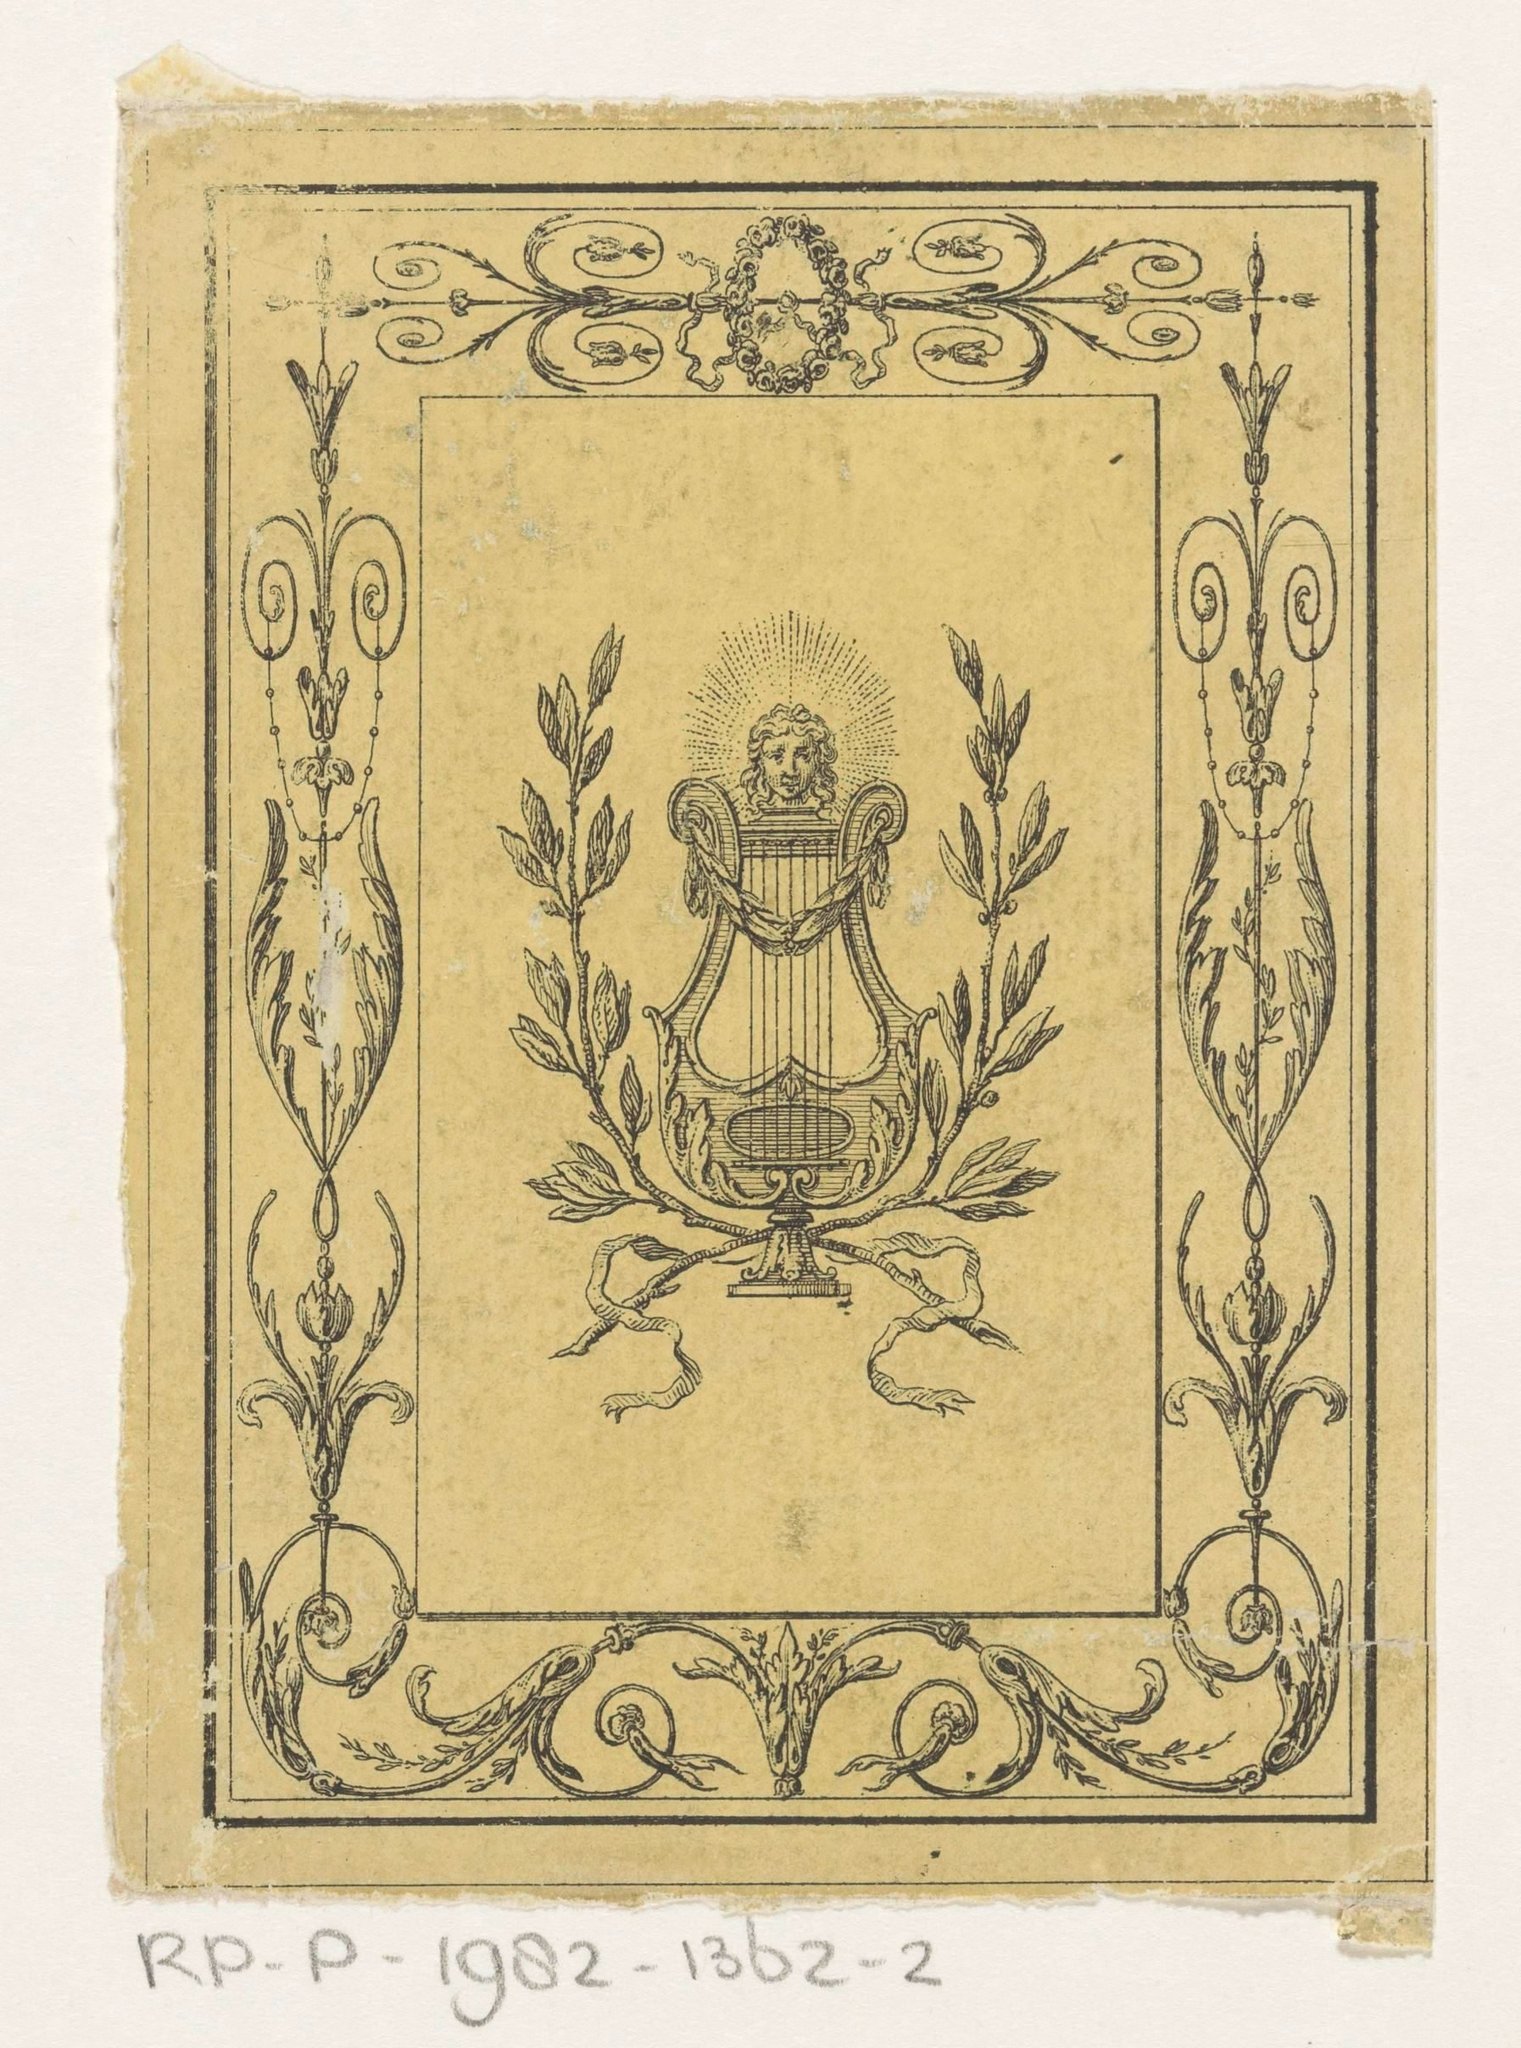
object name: print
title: Vignet met lier en Apollo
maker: Anonymous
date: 1821-1860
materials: paper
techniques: etching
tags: (story of) apollo (phoebus), piece of sculpture, reproduction of a piece of sculpture, vignette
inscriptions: collector's mark: Lugt 2760, collector's mark: Lugt 2228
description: Vignet met lier waarop het hoofd van Apollo in stralenkrans. In ornamentele omlijsting.